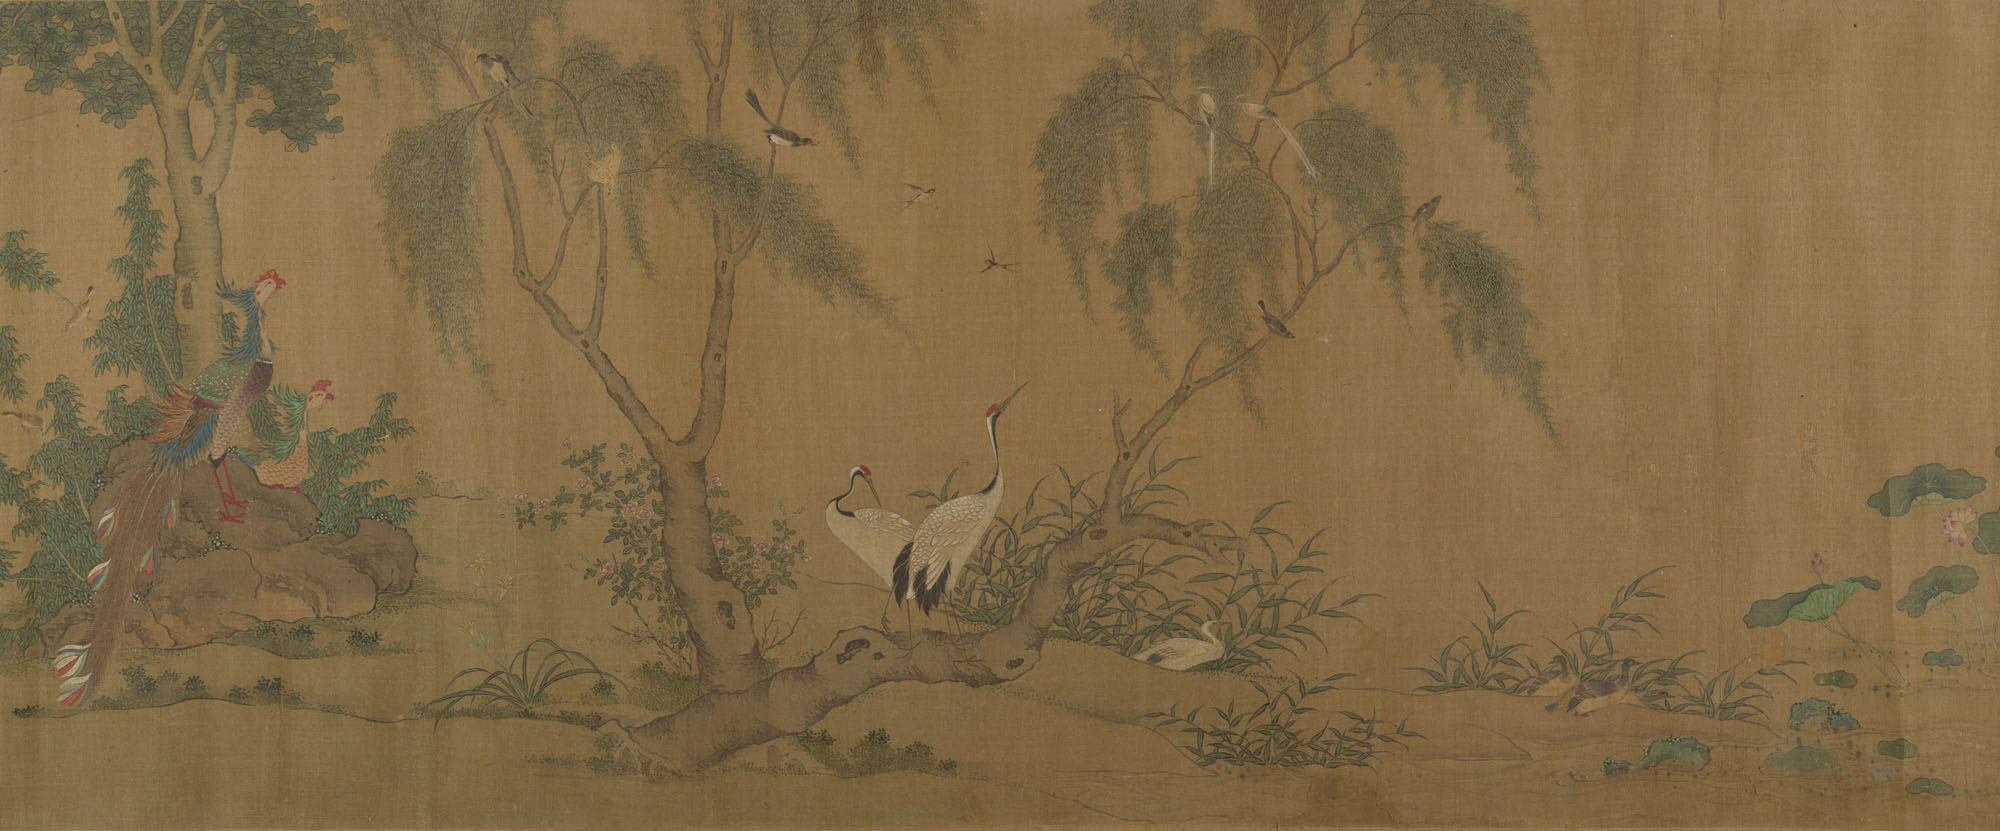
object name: handscroll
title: The Hundred Birds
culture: chinese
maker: unidentified artist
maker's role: artist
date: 1368-1911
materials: ink, silk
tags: birds,cranes